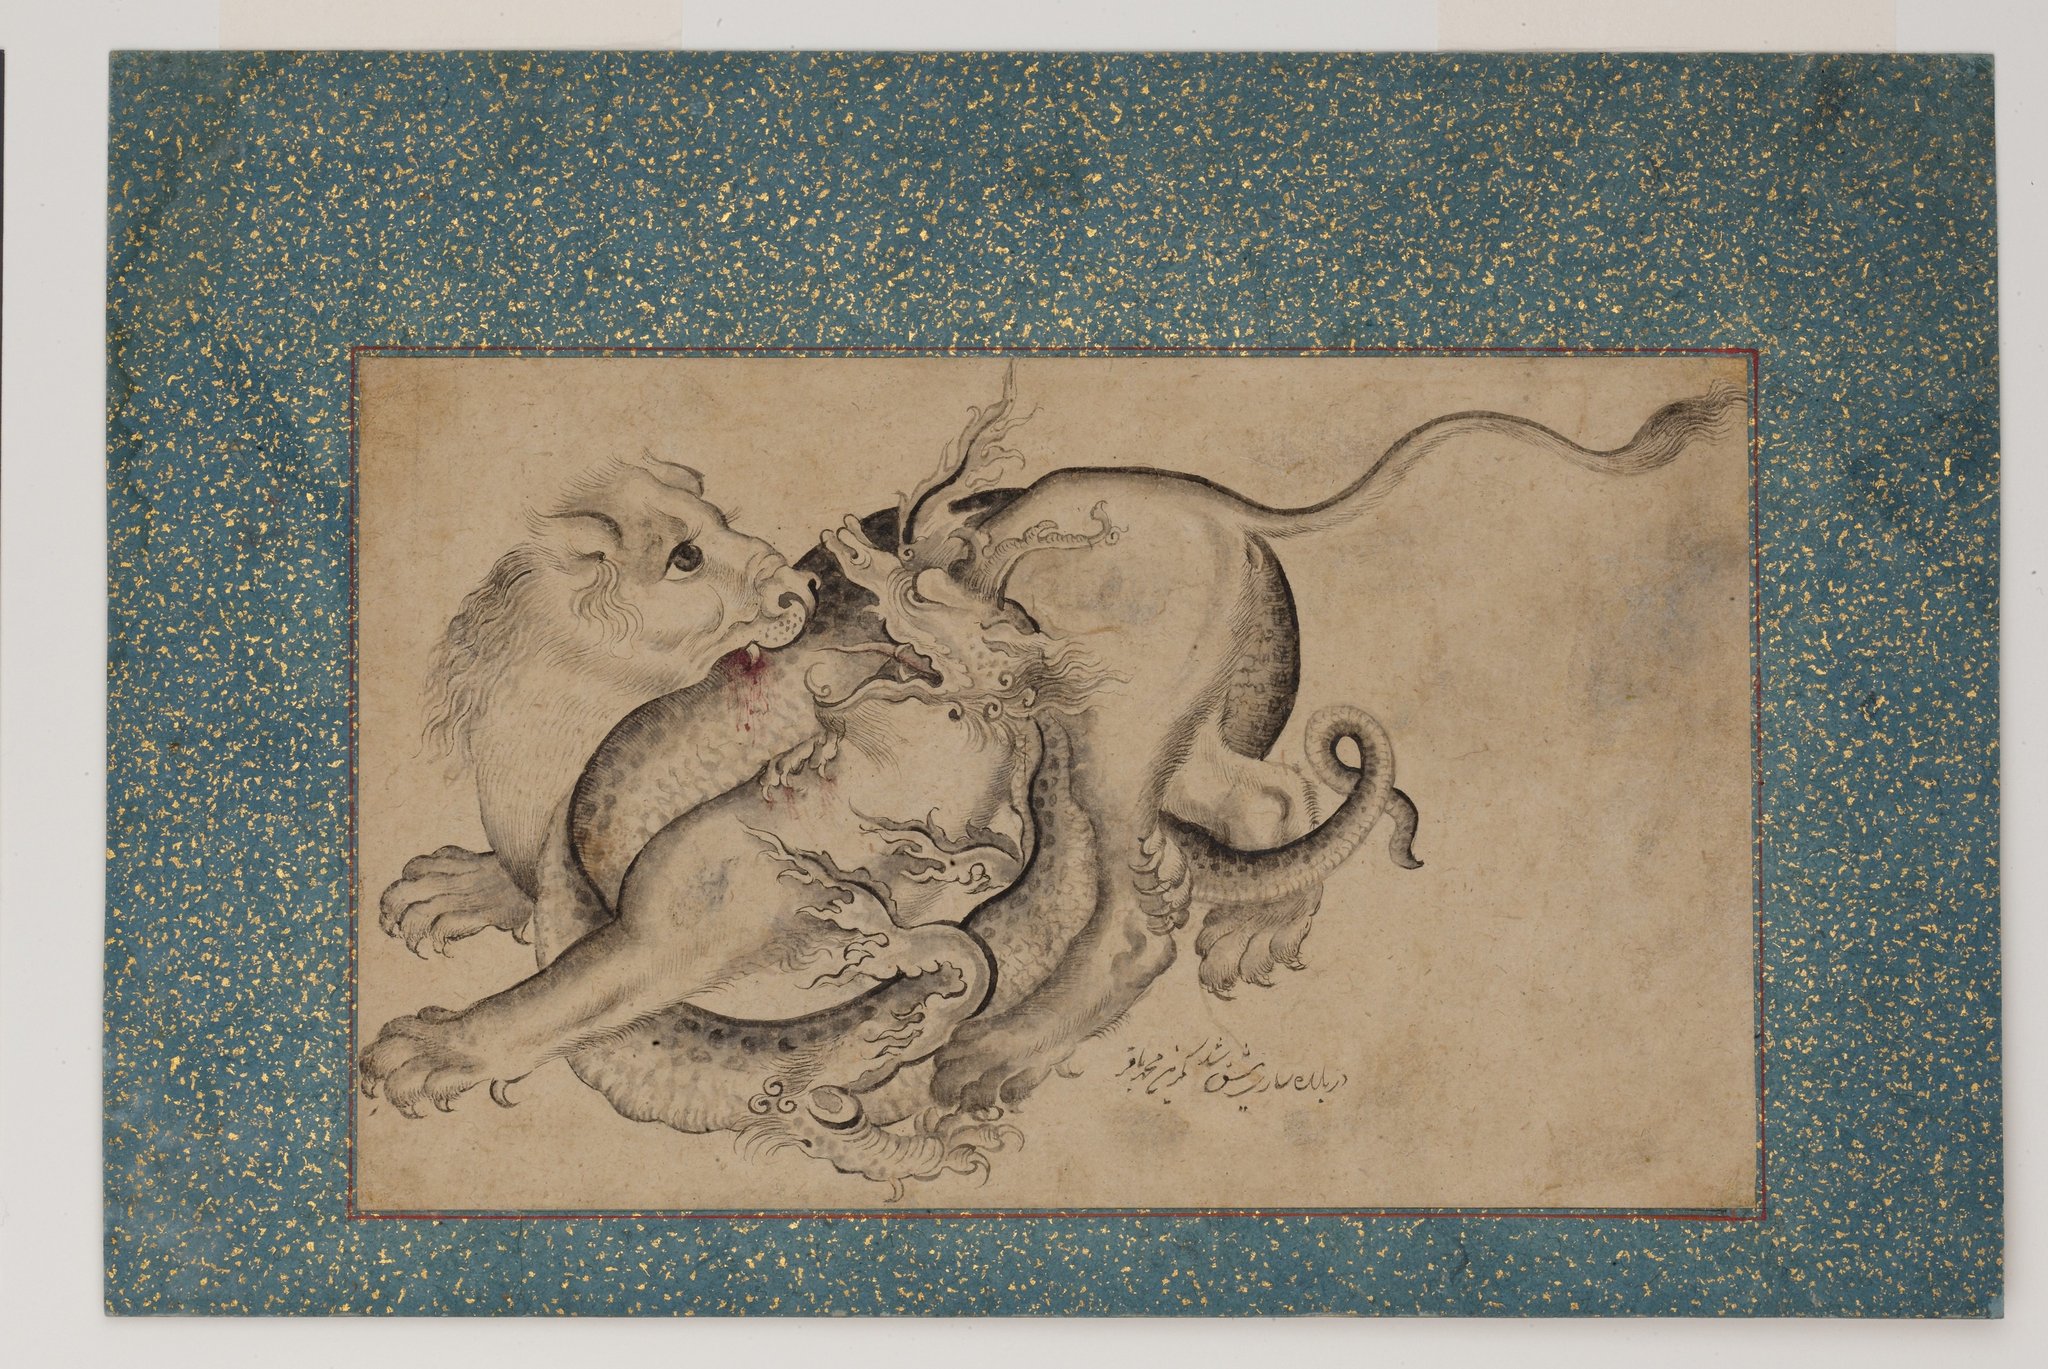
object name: illustrated single work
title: Lion and Dragon in Combat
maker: muhammad baqir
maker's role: artist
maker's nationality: iranian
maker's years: 1725-1790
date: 1751-1800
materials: ink, paper, watercolor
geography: iran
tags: dragons,lions